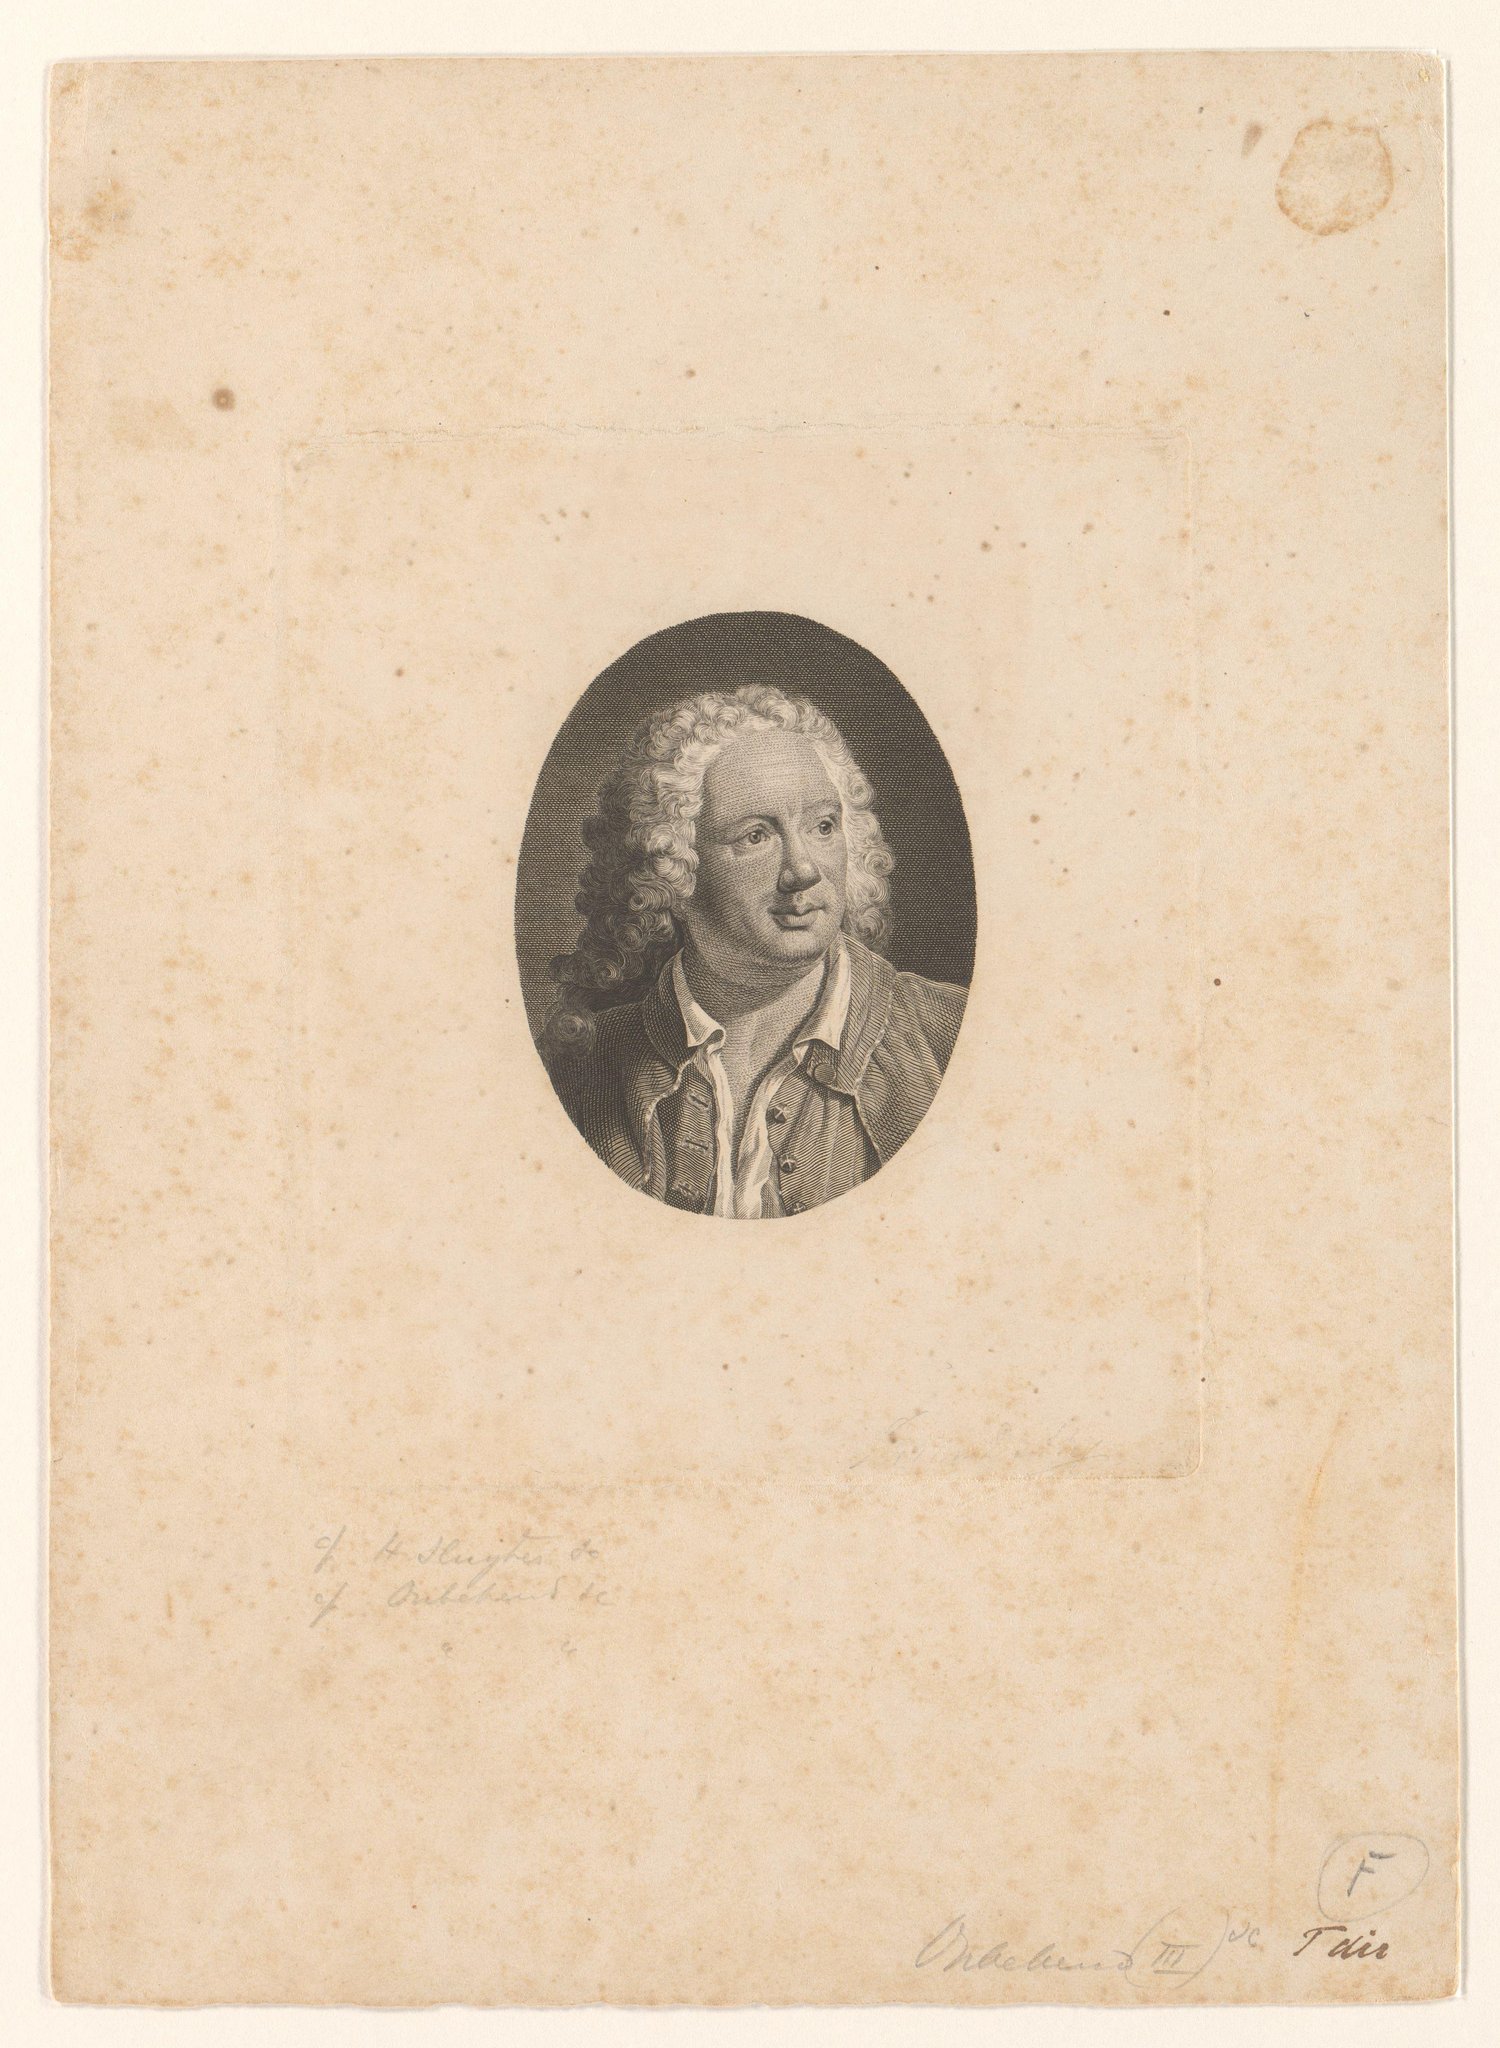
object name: print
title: Portret van Jean Baptiste Rousseau (1671-1741)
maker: hendrik d. jzn sluyter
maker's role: print maker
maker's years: 1839-1931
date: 1858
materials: paper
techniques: engraving, etching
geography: amsterdam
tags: paris, brussels, jean baptiste rousseau (1669-1741), historical persons, portrait of a writer